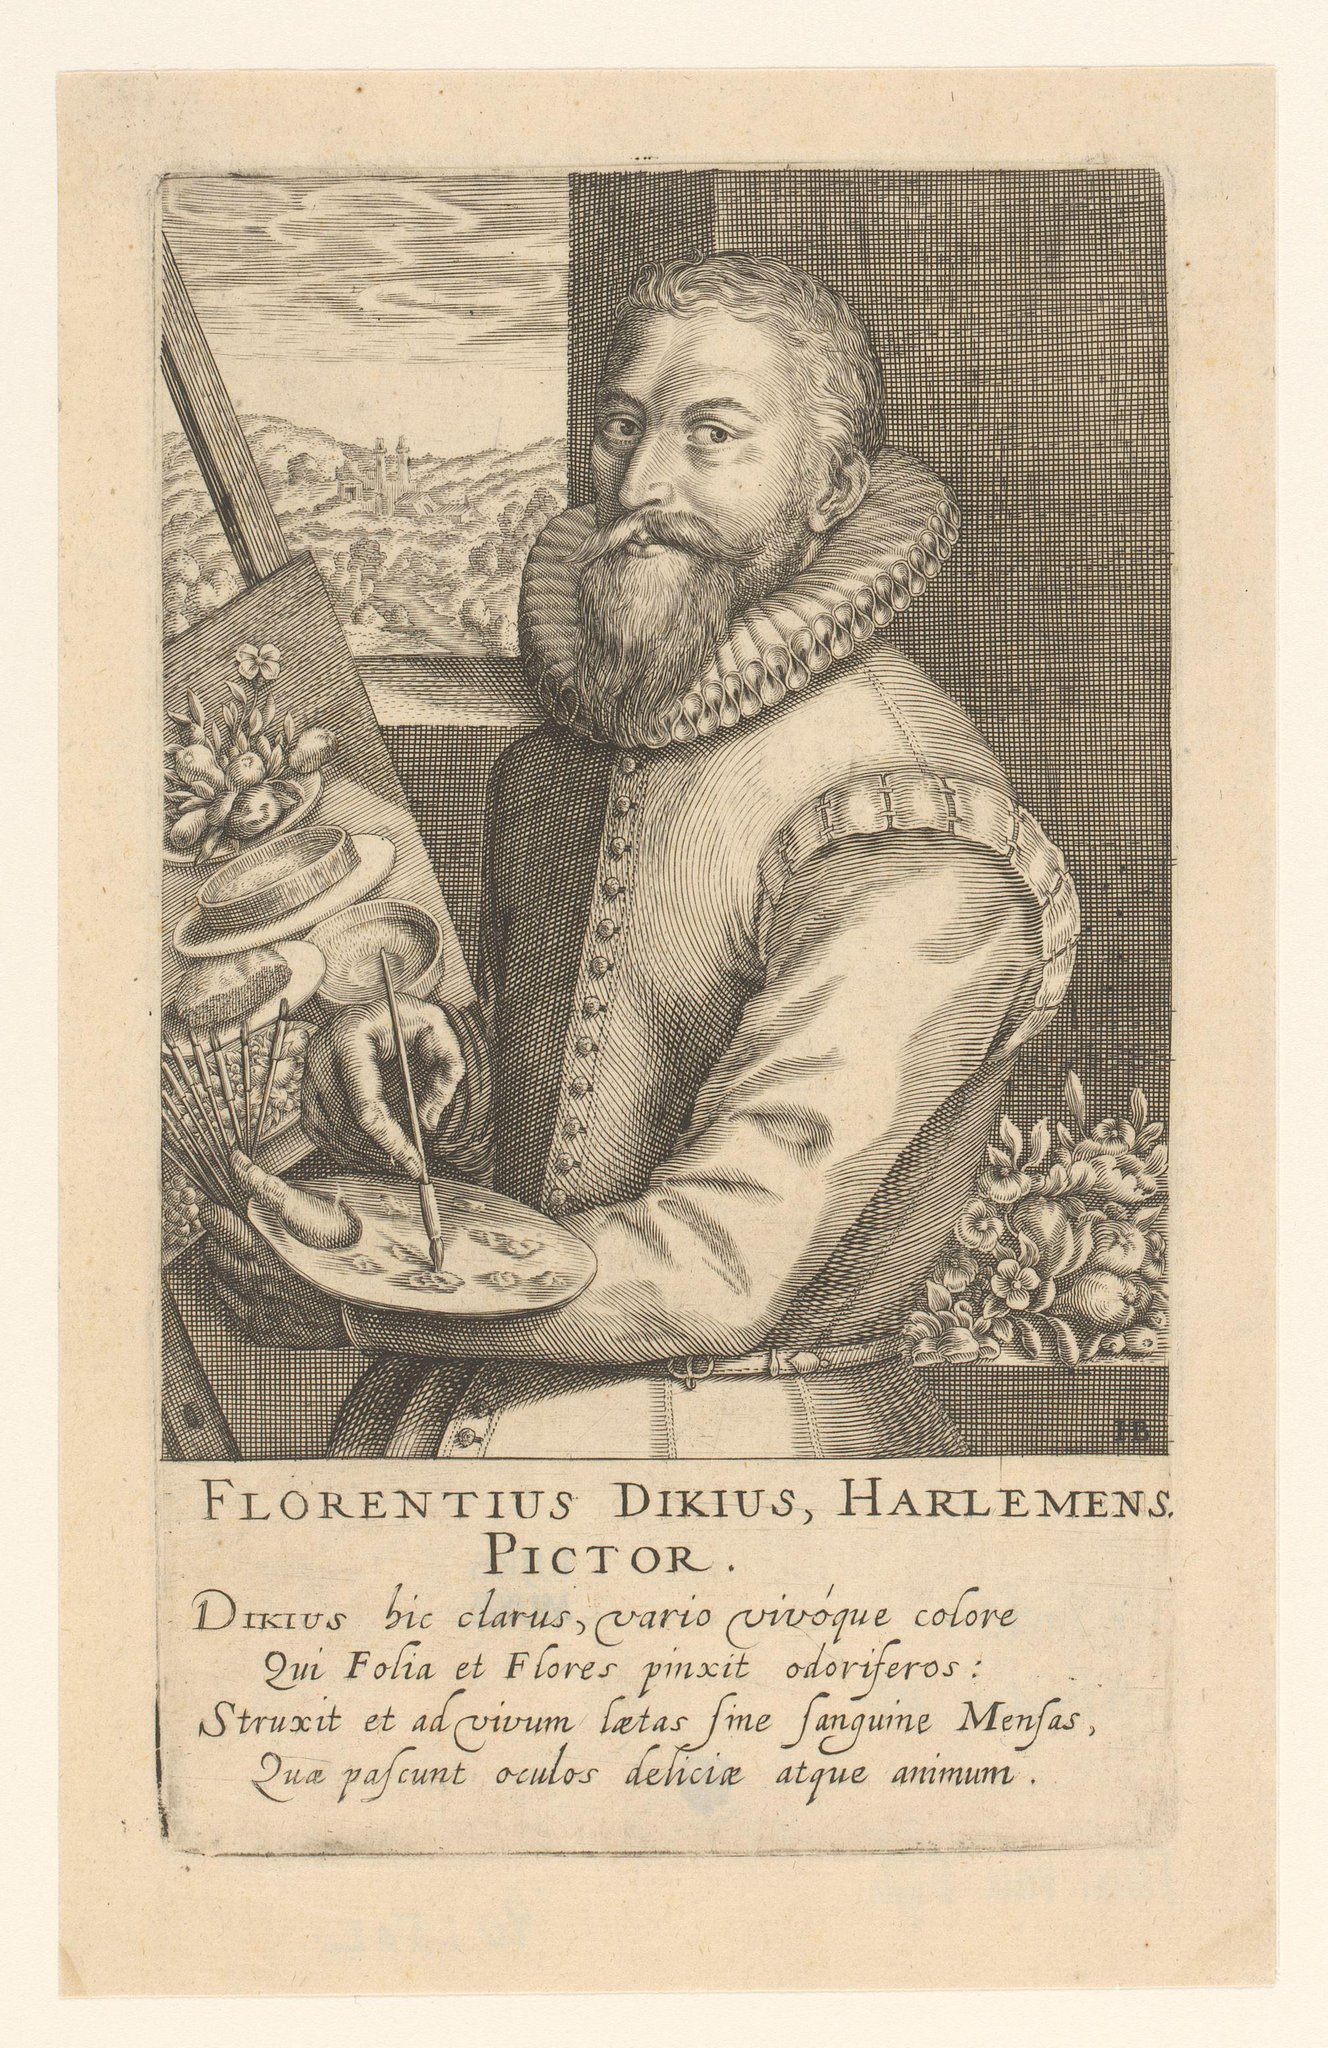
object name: print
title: Portretten van beroemde schilders uit de Lage Landen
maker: hendrick hondius (i)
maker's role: draughtsman, print maker, publisher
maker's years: 1573-1650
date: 1610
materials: paper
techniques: engraving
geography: the hague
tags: haarlem, painter, floris claesz van dijck, historical persons, portrait, self-portrait of painter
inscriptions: collector's mark: Lugt 2166, collector's mark: Lugt 2760